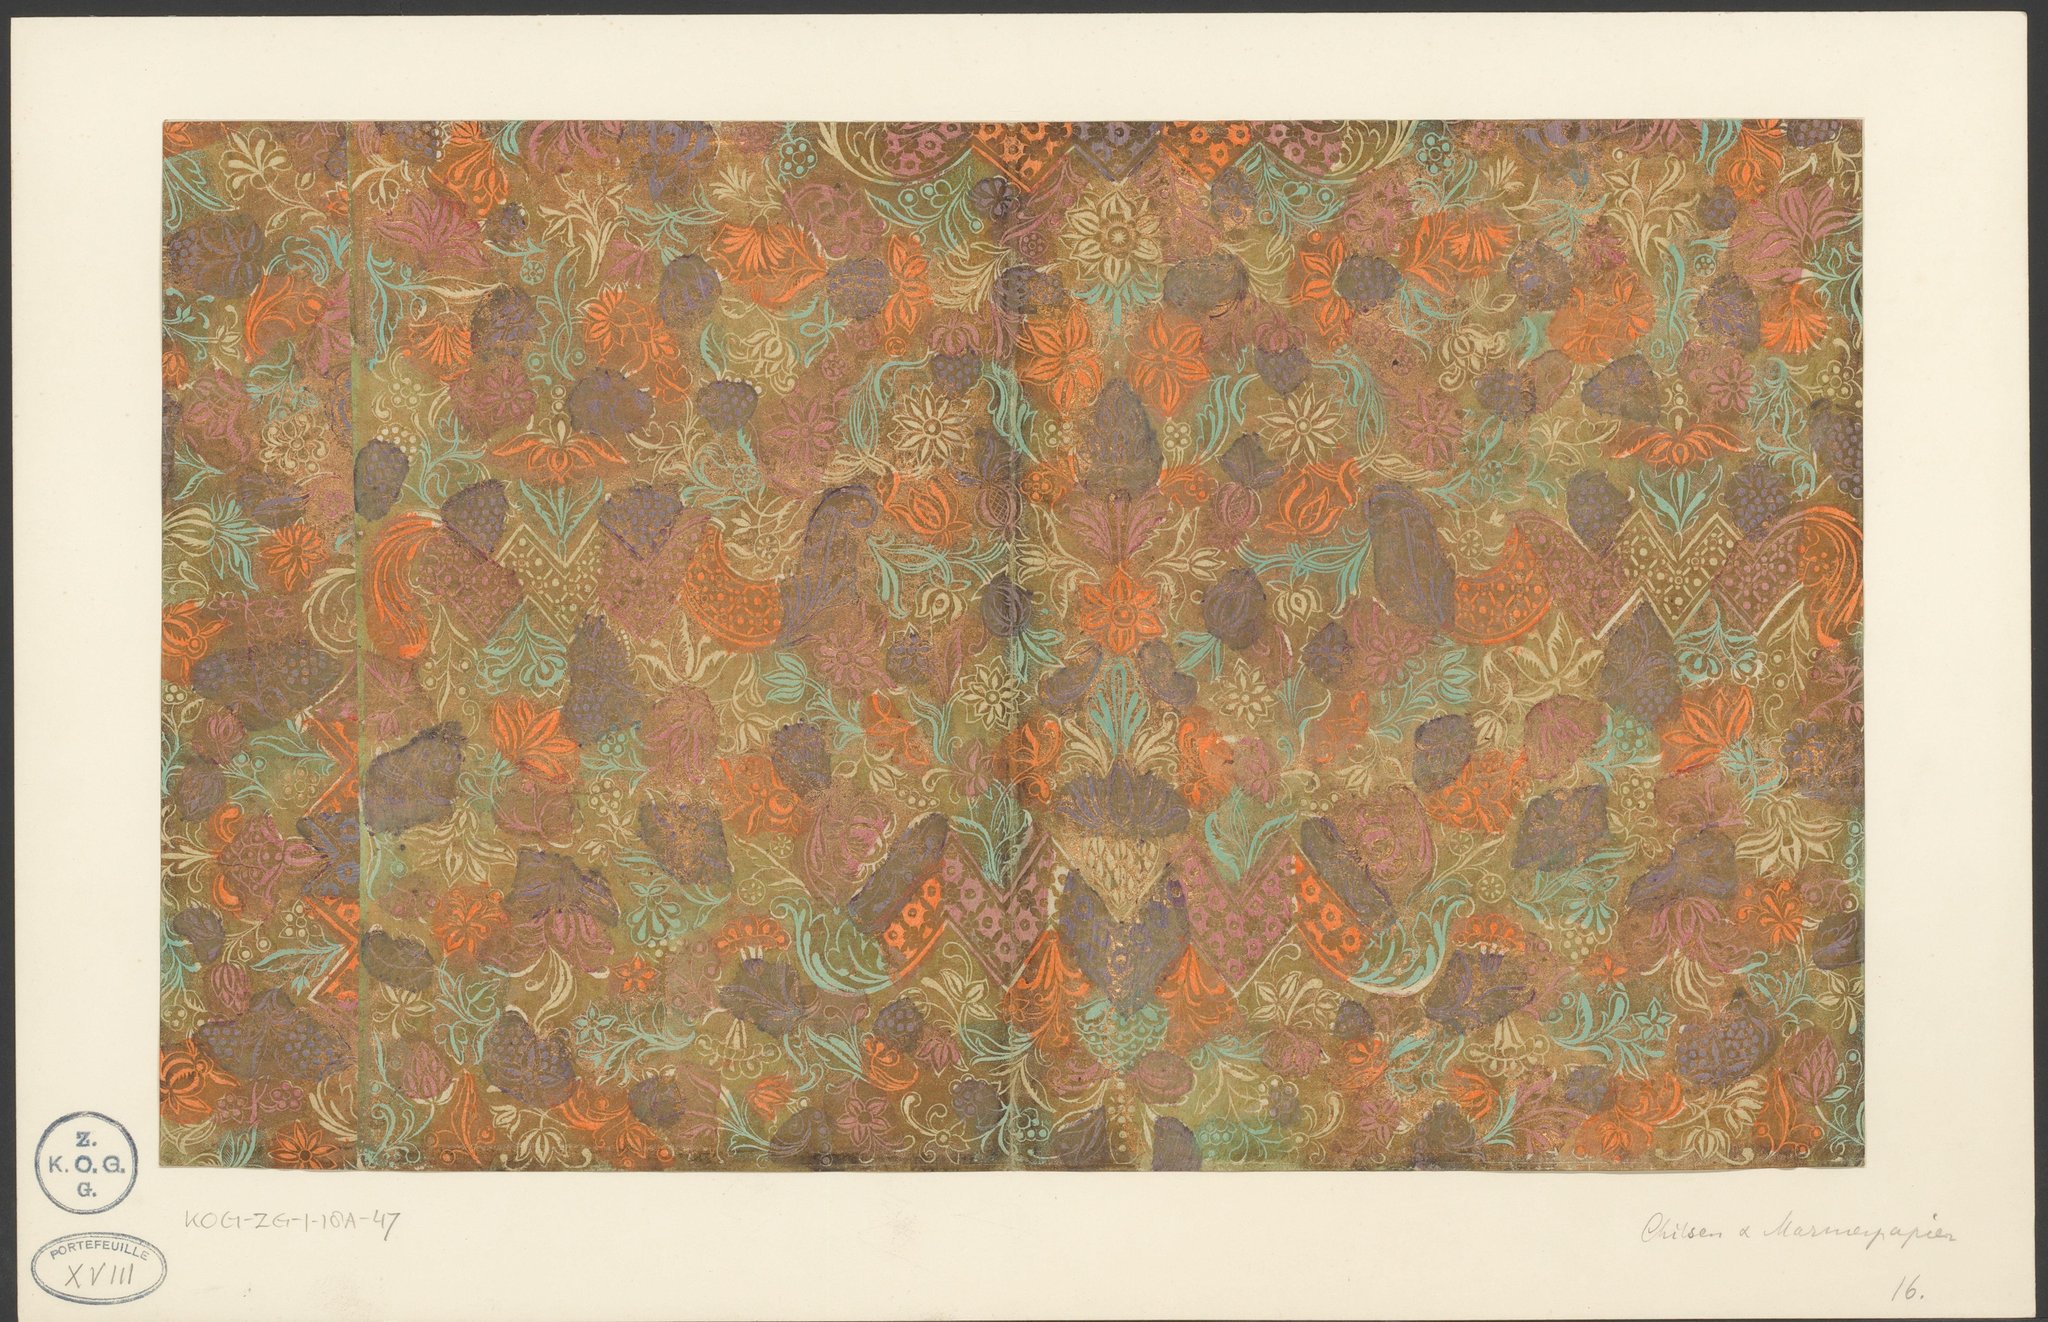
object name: brocade paper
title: Blad met een patroon van bloemen en bladeren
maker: Anonymous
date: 1700-1799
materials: gold leaf, paint, paper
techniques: relief print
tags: flowers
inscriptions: collector's mark: Lugt 1641, stamp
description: Blad met een patroon van bloemen en bladeren. Onderwerpsrubrieken binnen de Atlas Zeden en Gewoonten: Schoone kunsten, Sitsen en marmerpapier.